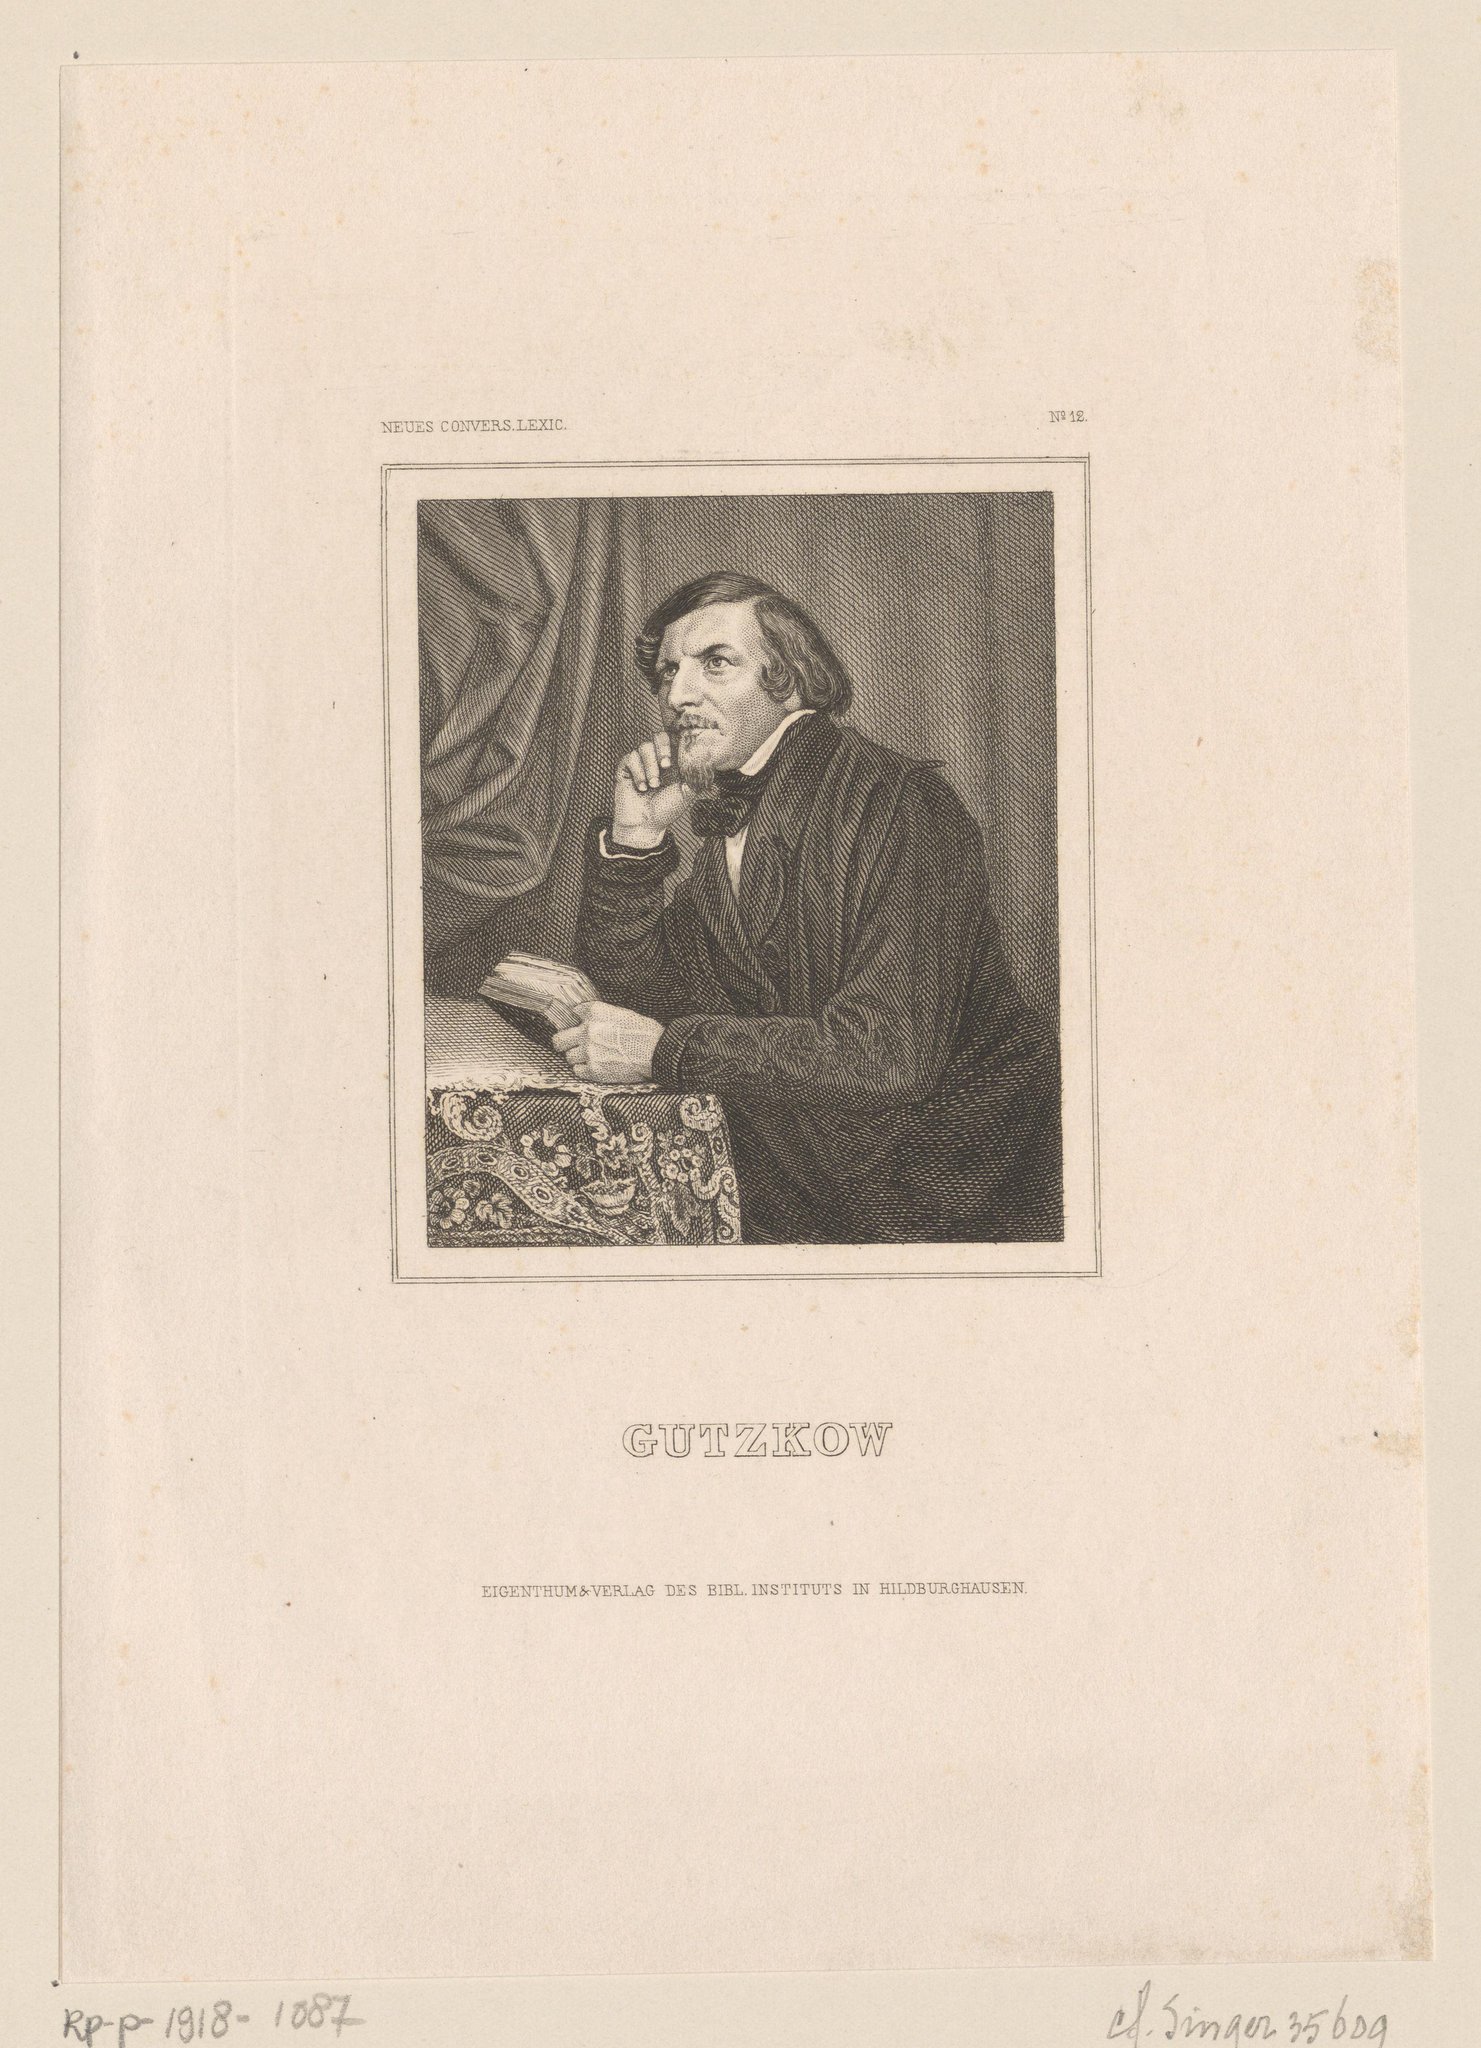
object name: book illustration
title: Portret van Karl Gutzkow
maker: Anonymous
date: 1857-1861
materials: paper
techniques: lithograph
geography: hildburghausen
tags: historical persons, portrait of a writer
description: Prent uit: Neues Conversations-Lexikon für alle Stände. Hildburgshausen: Bibliographisches Institut, [1857-1861].